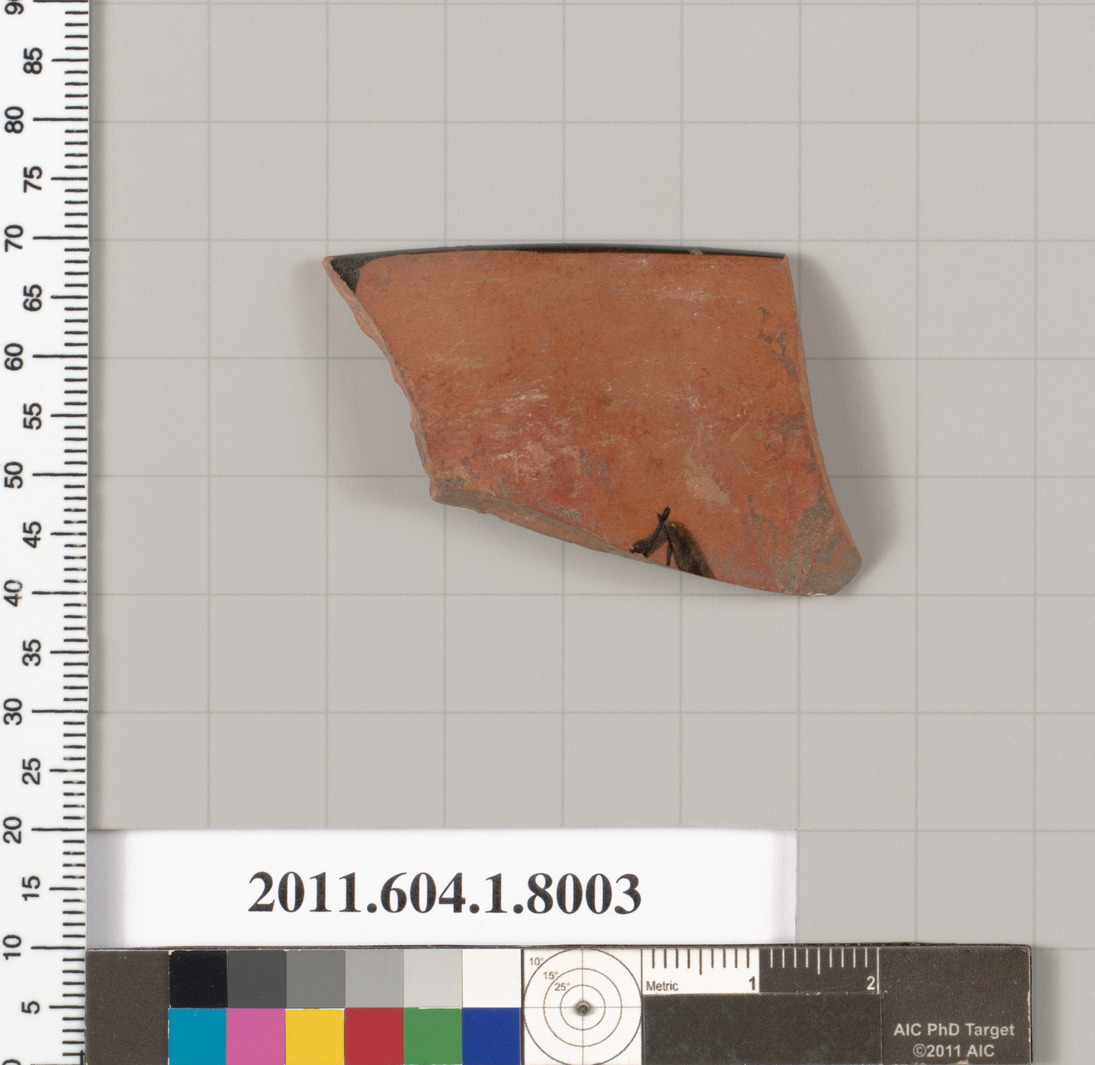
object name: kylix fragment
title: Terracotta rim fragment of a kylix (drinking cup)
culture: greek, attic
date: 460-450 BCE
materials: terracotta